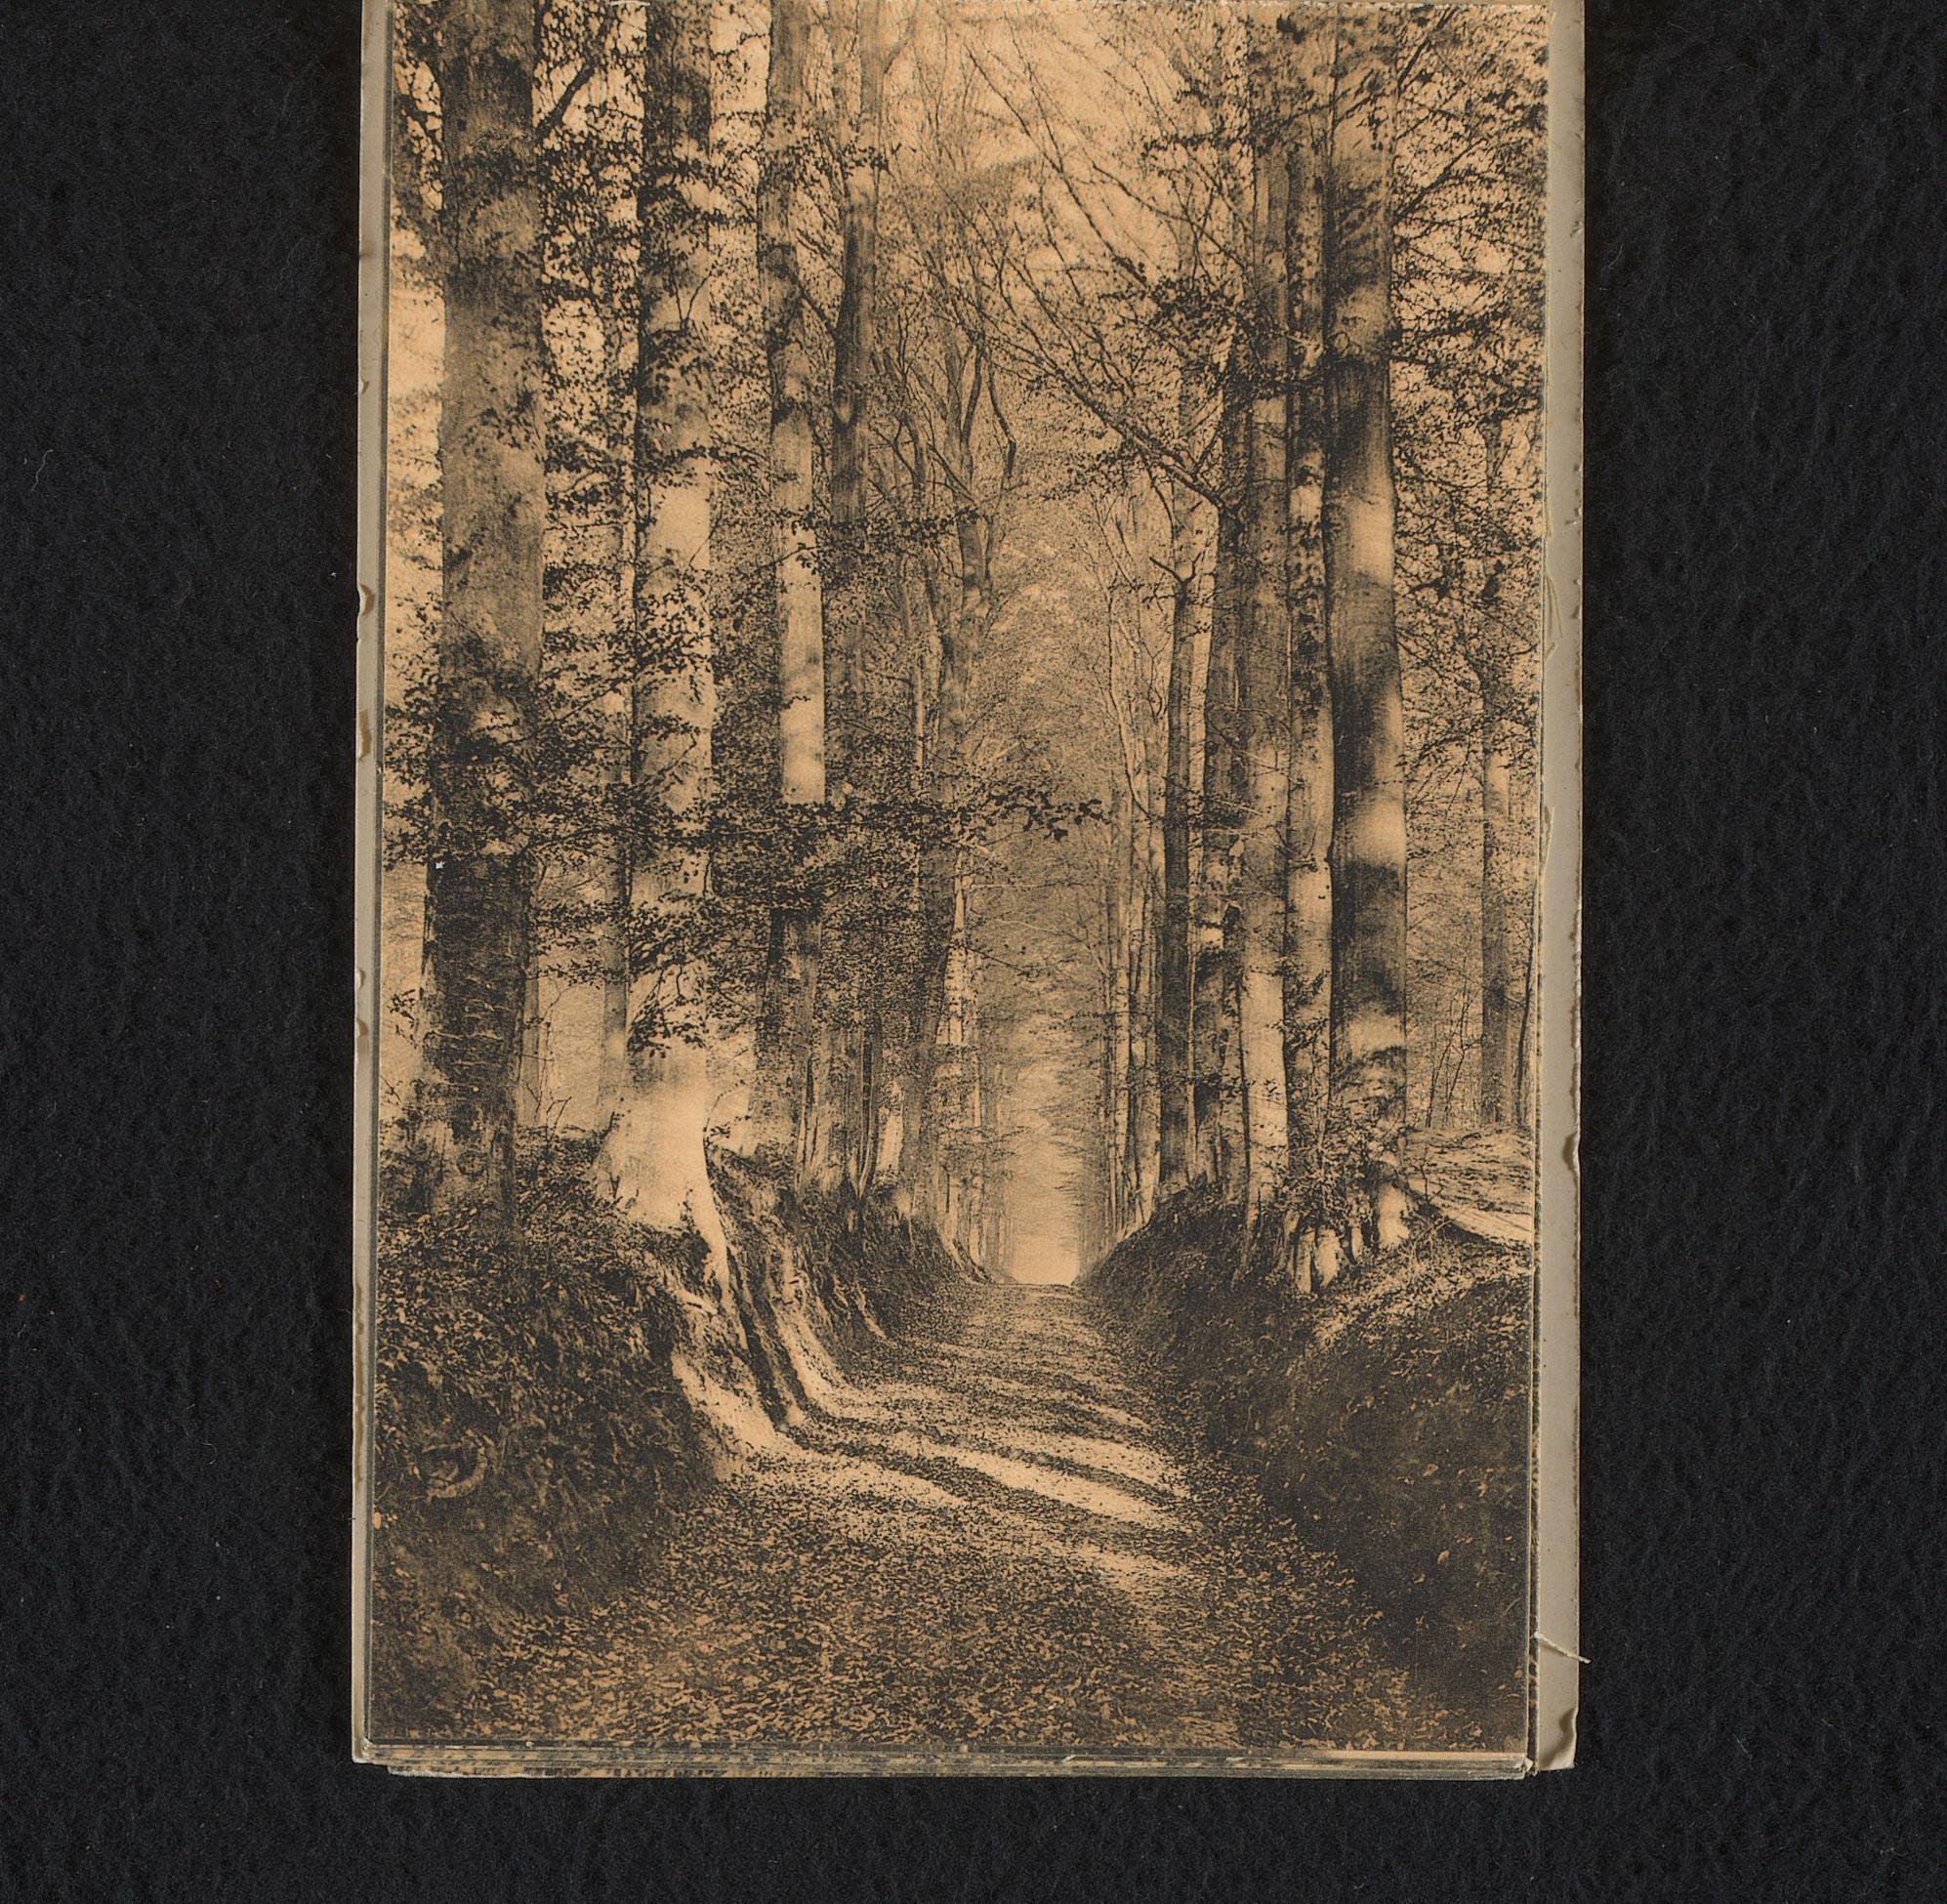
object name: ansichtkaart, prentbriefkaart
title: Drève du Comte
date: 1909-1914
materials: cardboard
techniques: photograph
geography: etterbeek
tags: forest path or lane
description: Prentbriefkaart maakt deel uit van een album.